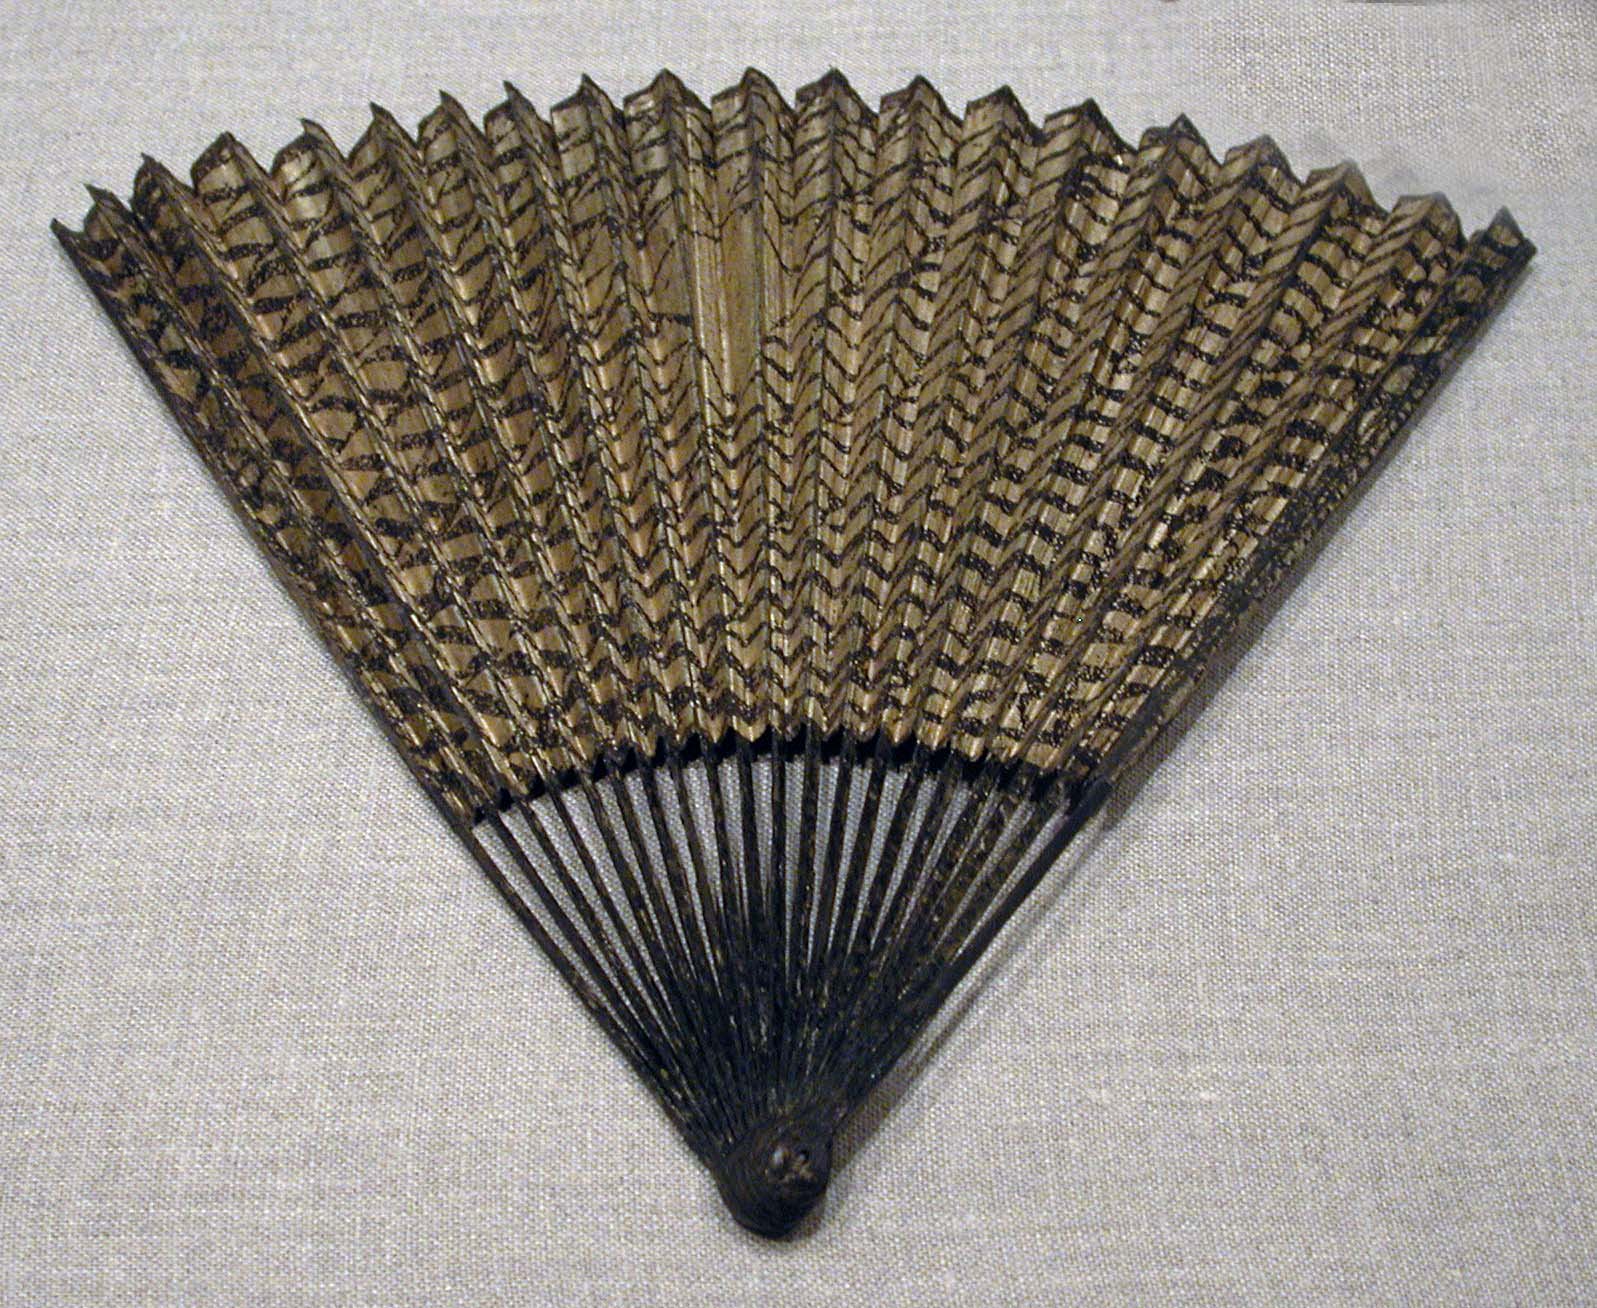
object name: folding fan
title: Folding Fan with Fishing Net Decoration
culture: chinese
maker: unidentified artist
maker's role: artist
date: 1567-1633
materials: bamboo, gold, ink, paper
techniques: lacquer